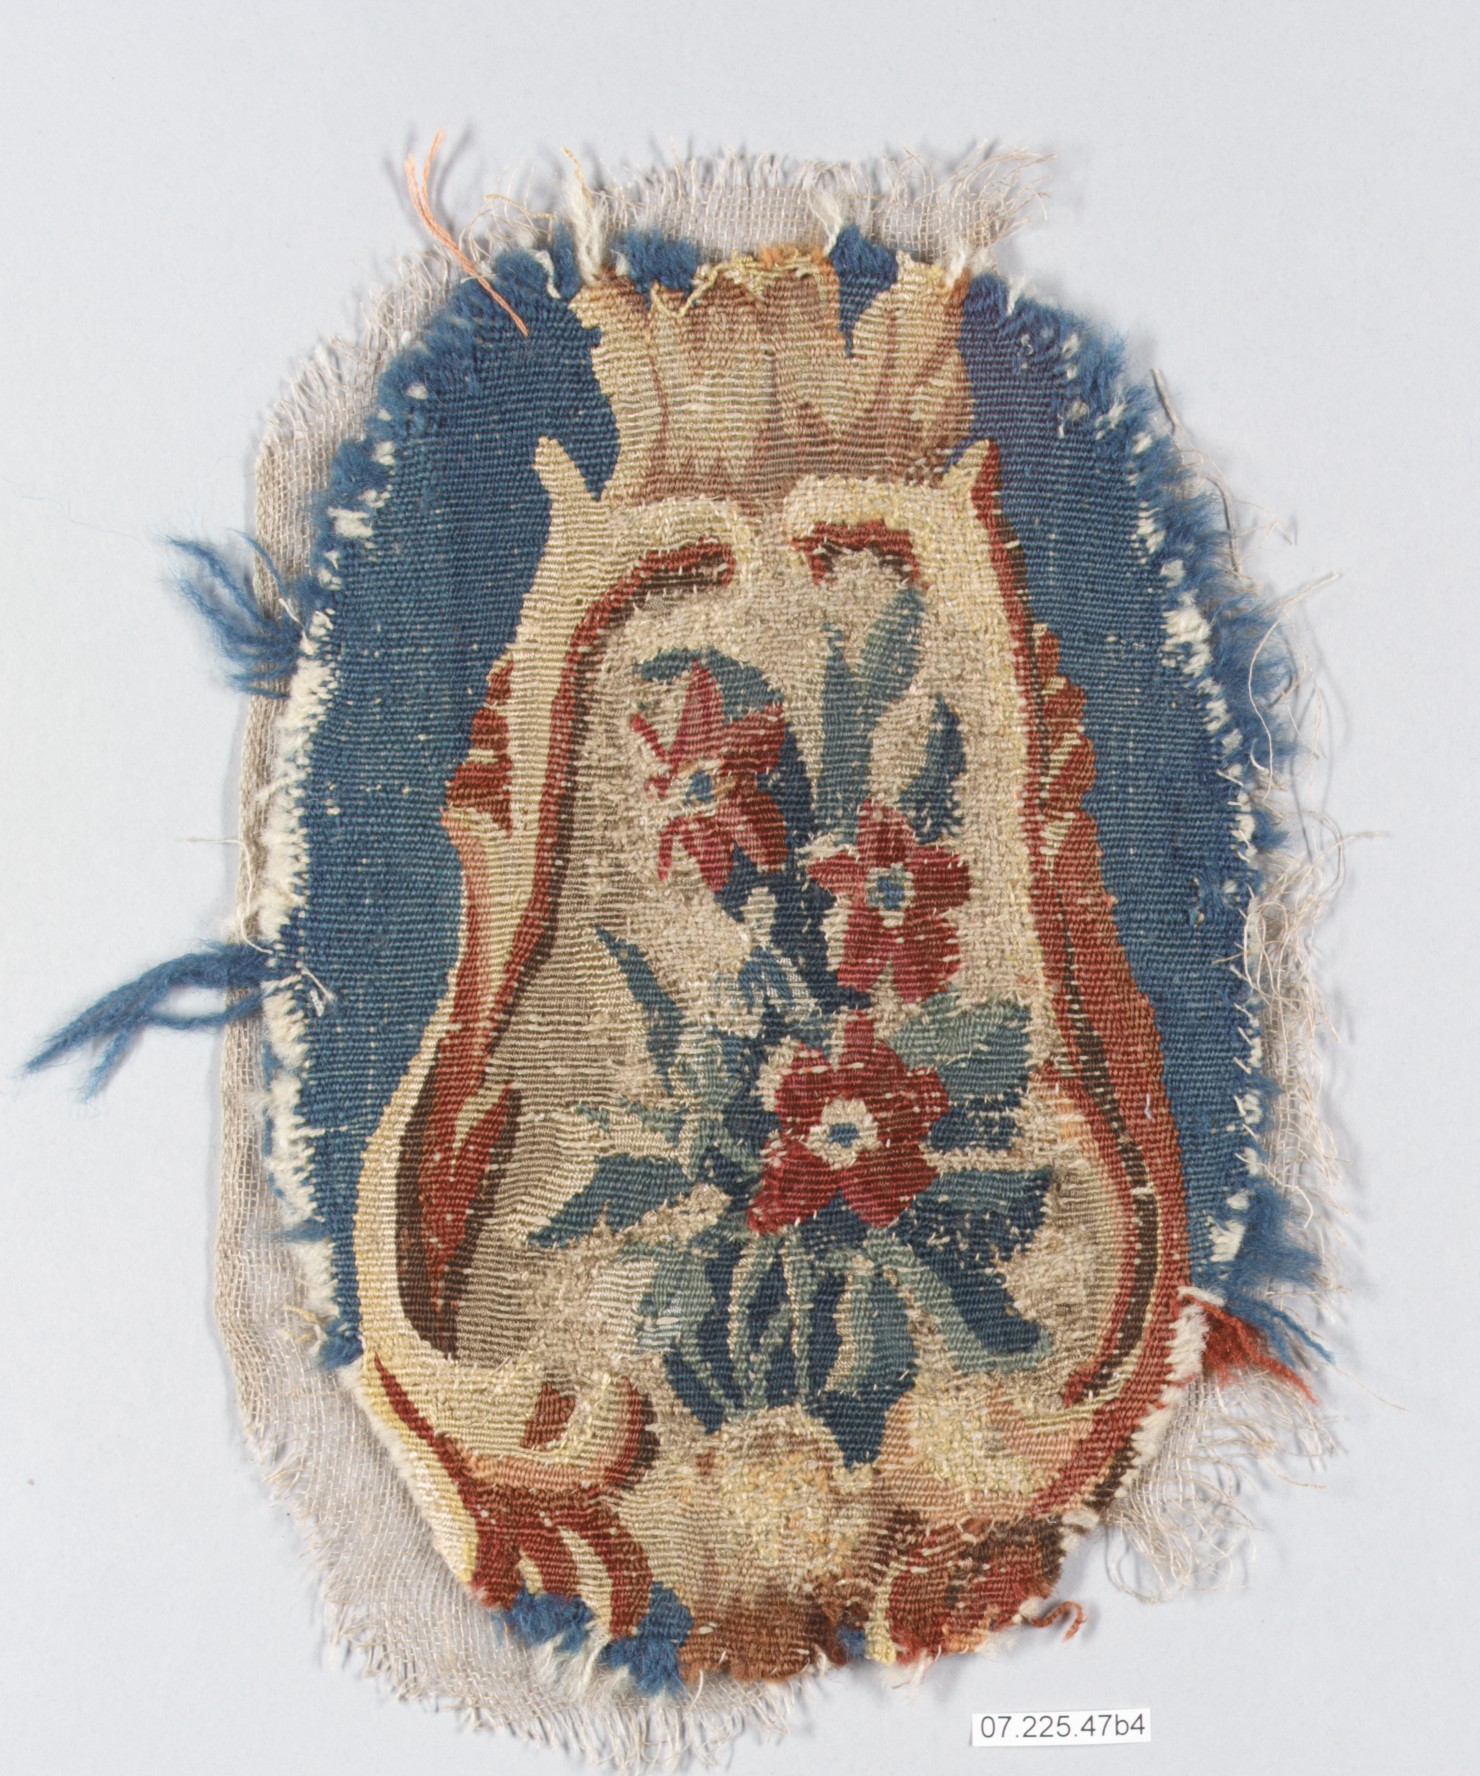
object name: upholstery panel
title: Rocaille cartouche with flowers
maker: beauvais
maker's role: manufactory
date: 1735-1750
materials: silk, wool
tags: flowers